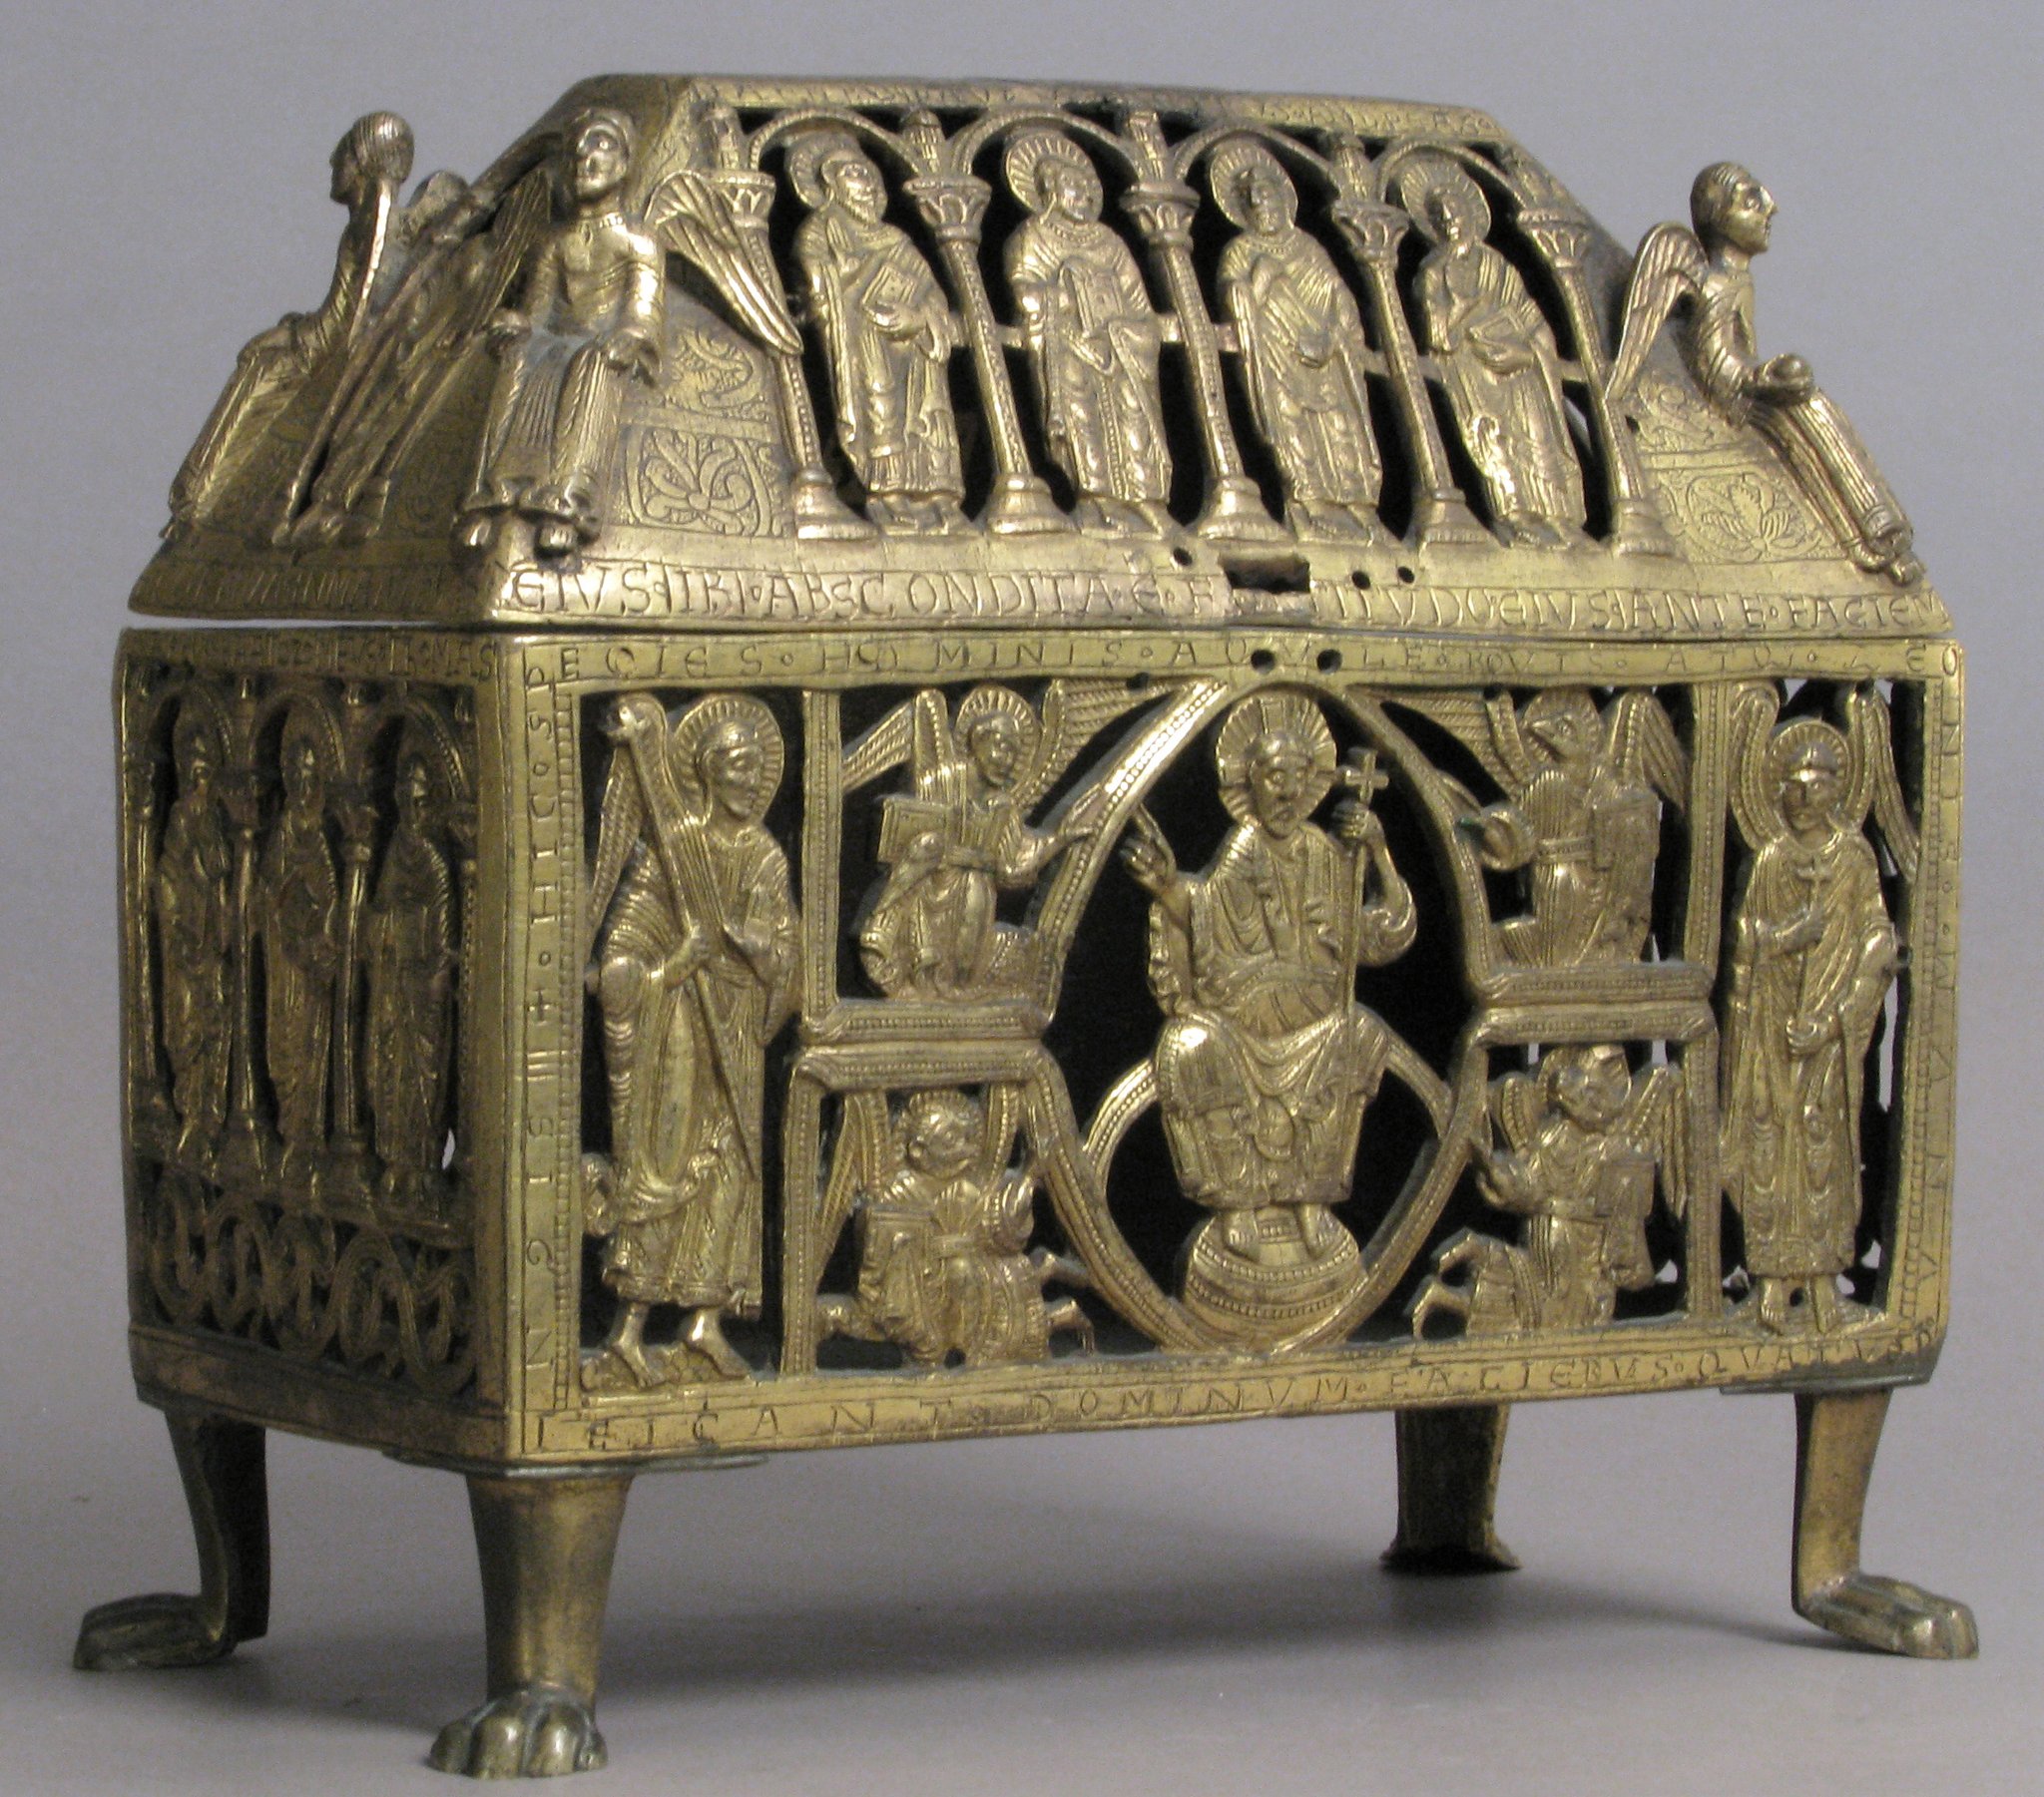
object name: chasse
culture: german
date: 1801-1900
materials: copper alloy, gilt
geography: germany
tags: angels,saints